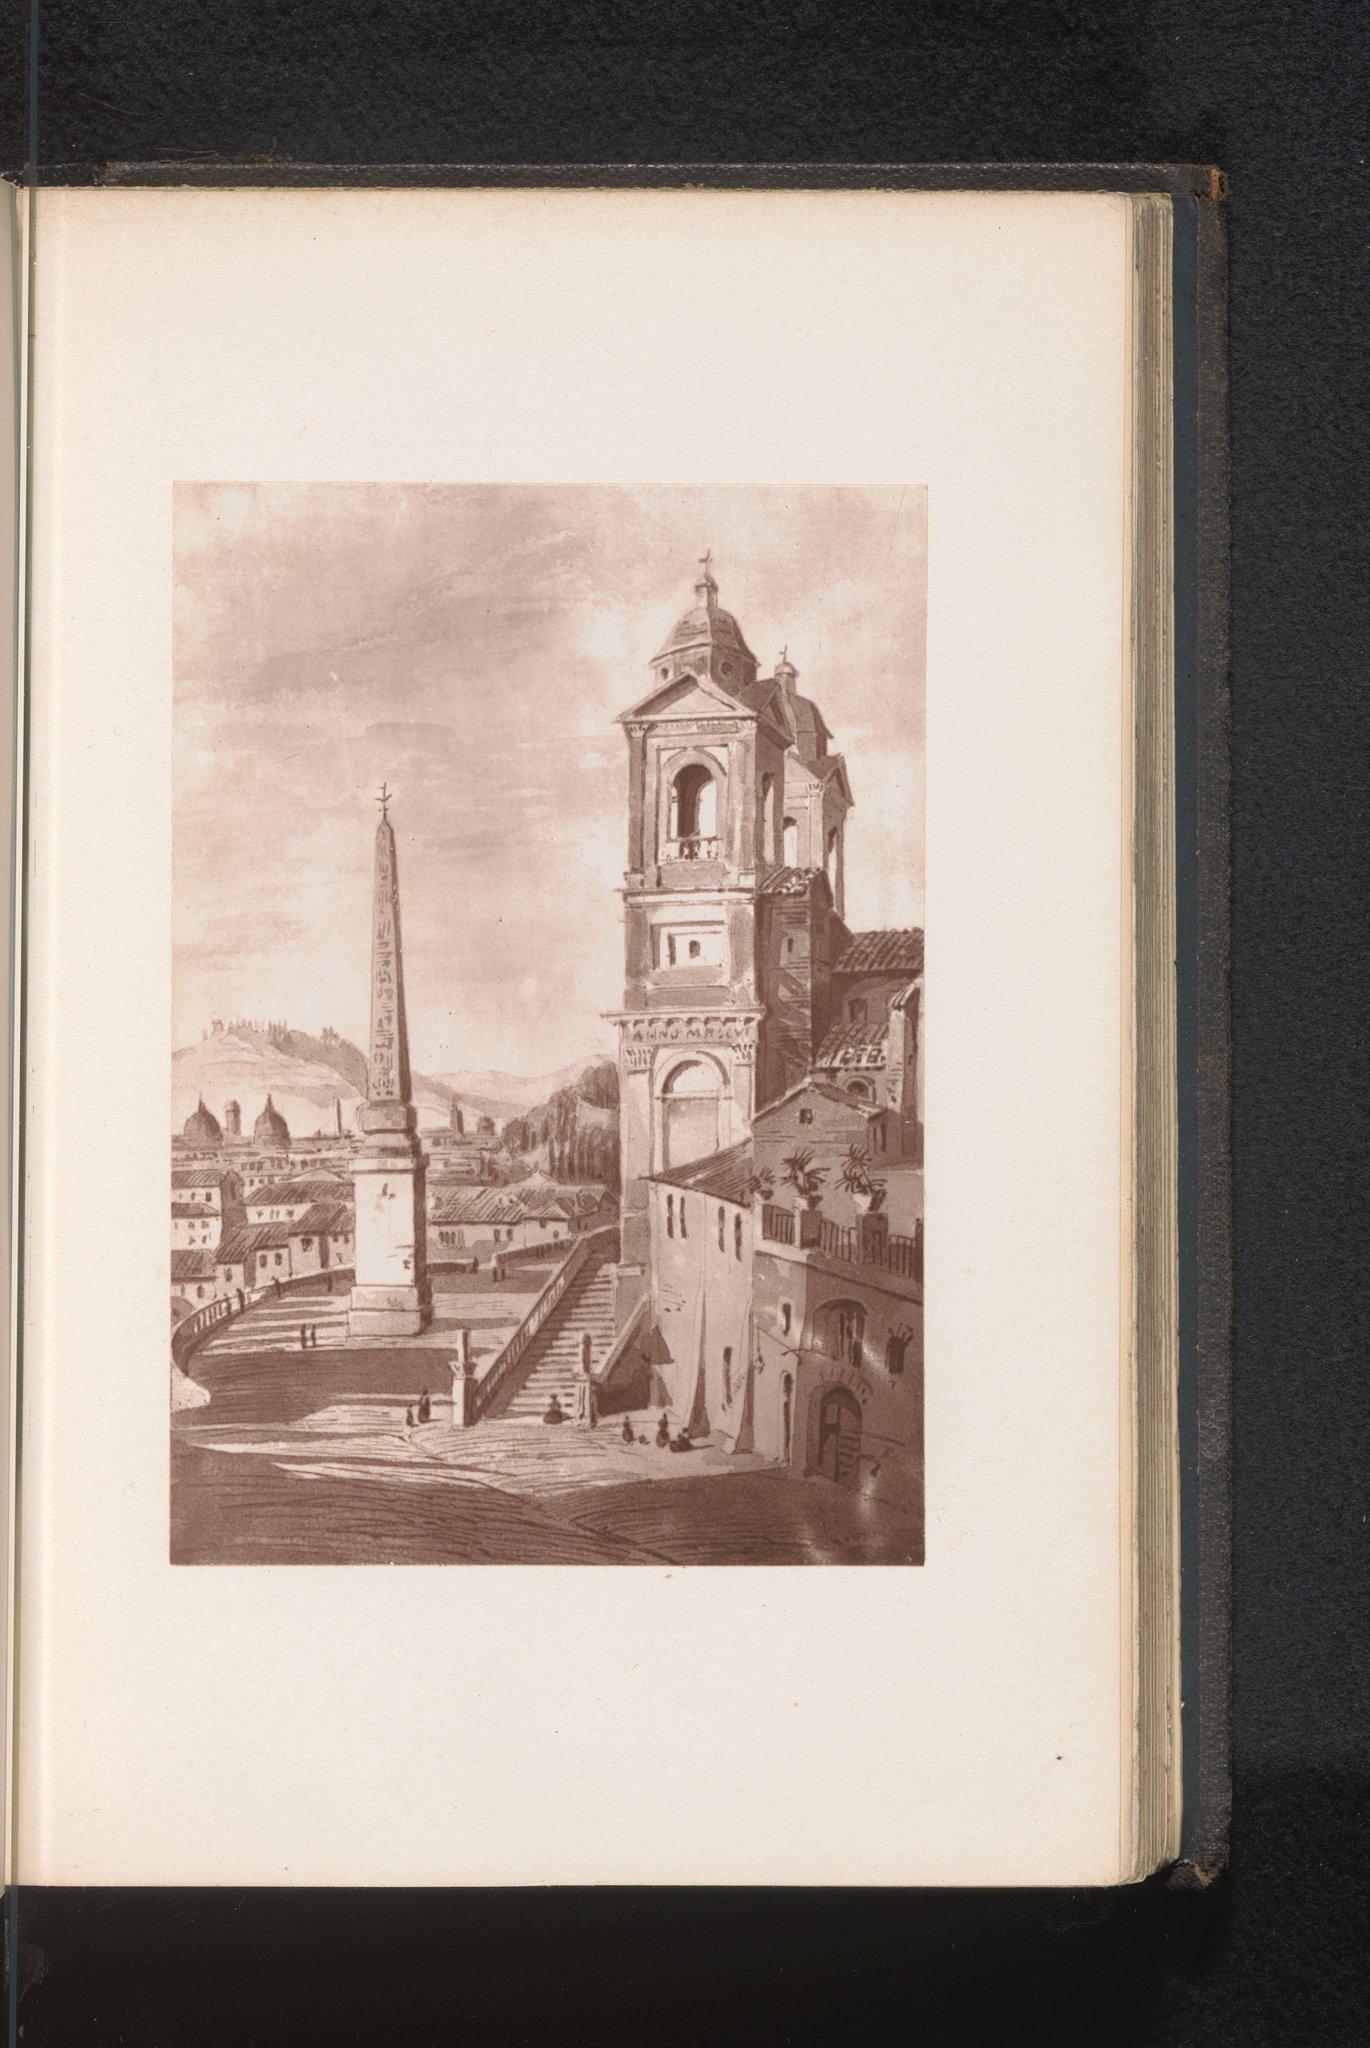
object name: page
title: Fotoreproductie van een schildering, voorstellende een gezicht op het plein voor de Trinità dei Monti te Rome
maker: Anonymous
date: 1866-1876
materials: paper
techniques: woodburytype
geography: rome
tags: square, place, circus, etc., obelisk, needle, church (exterior)